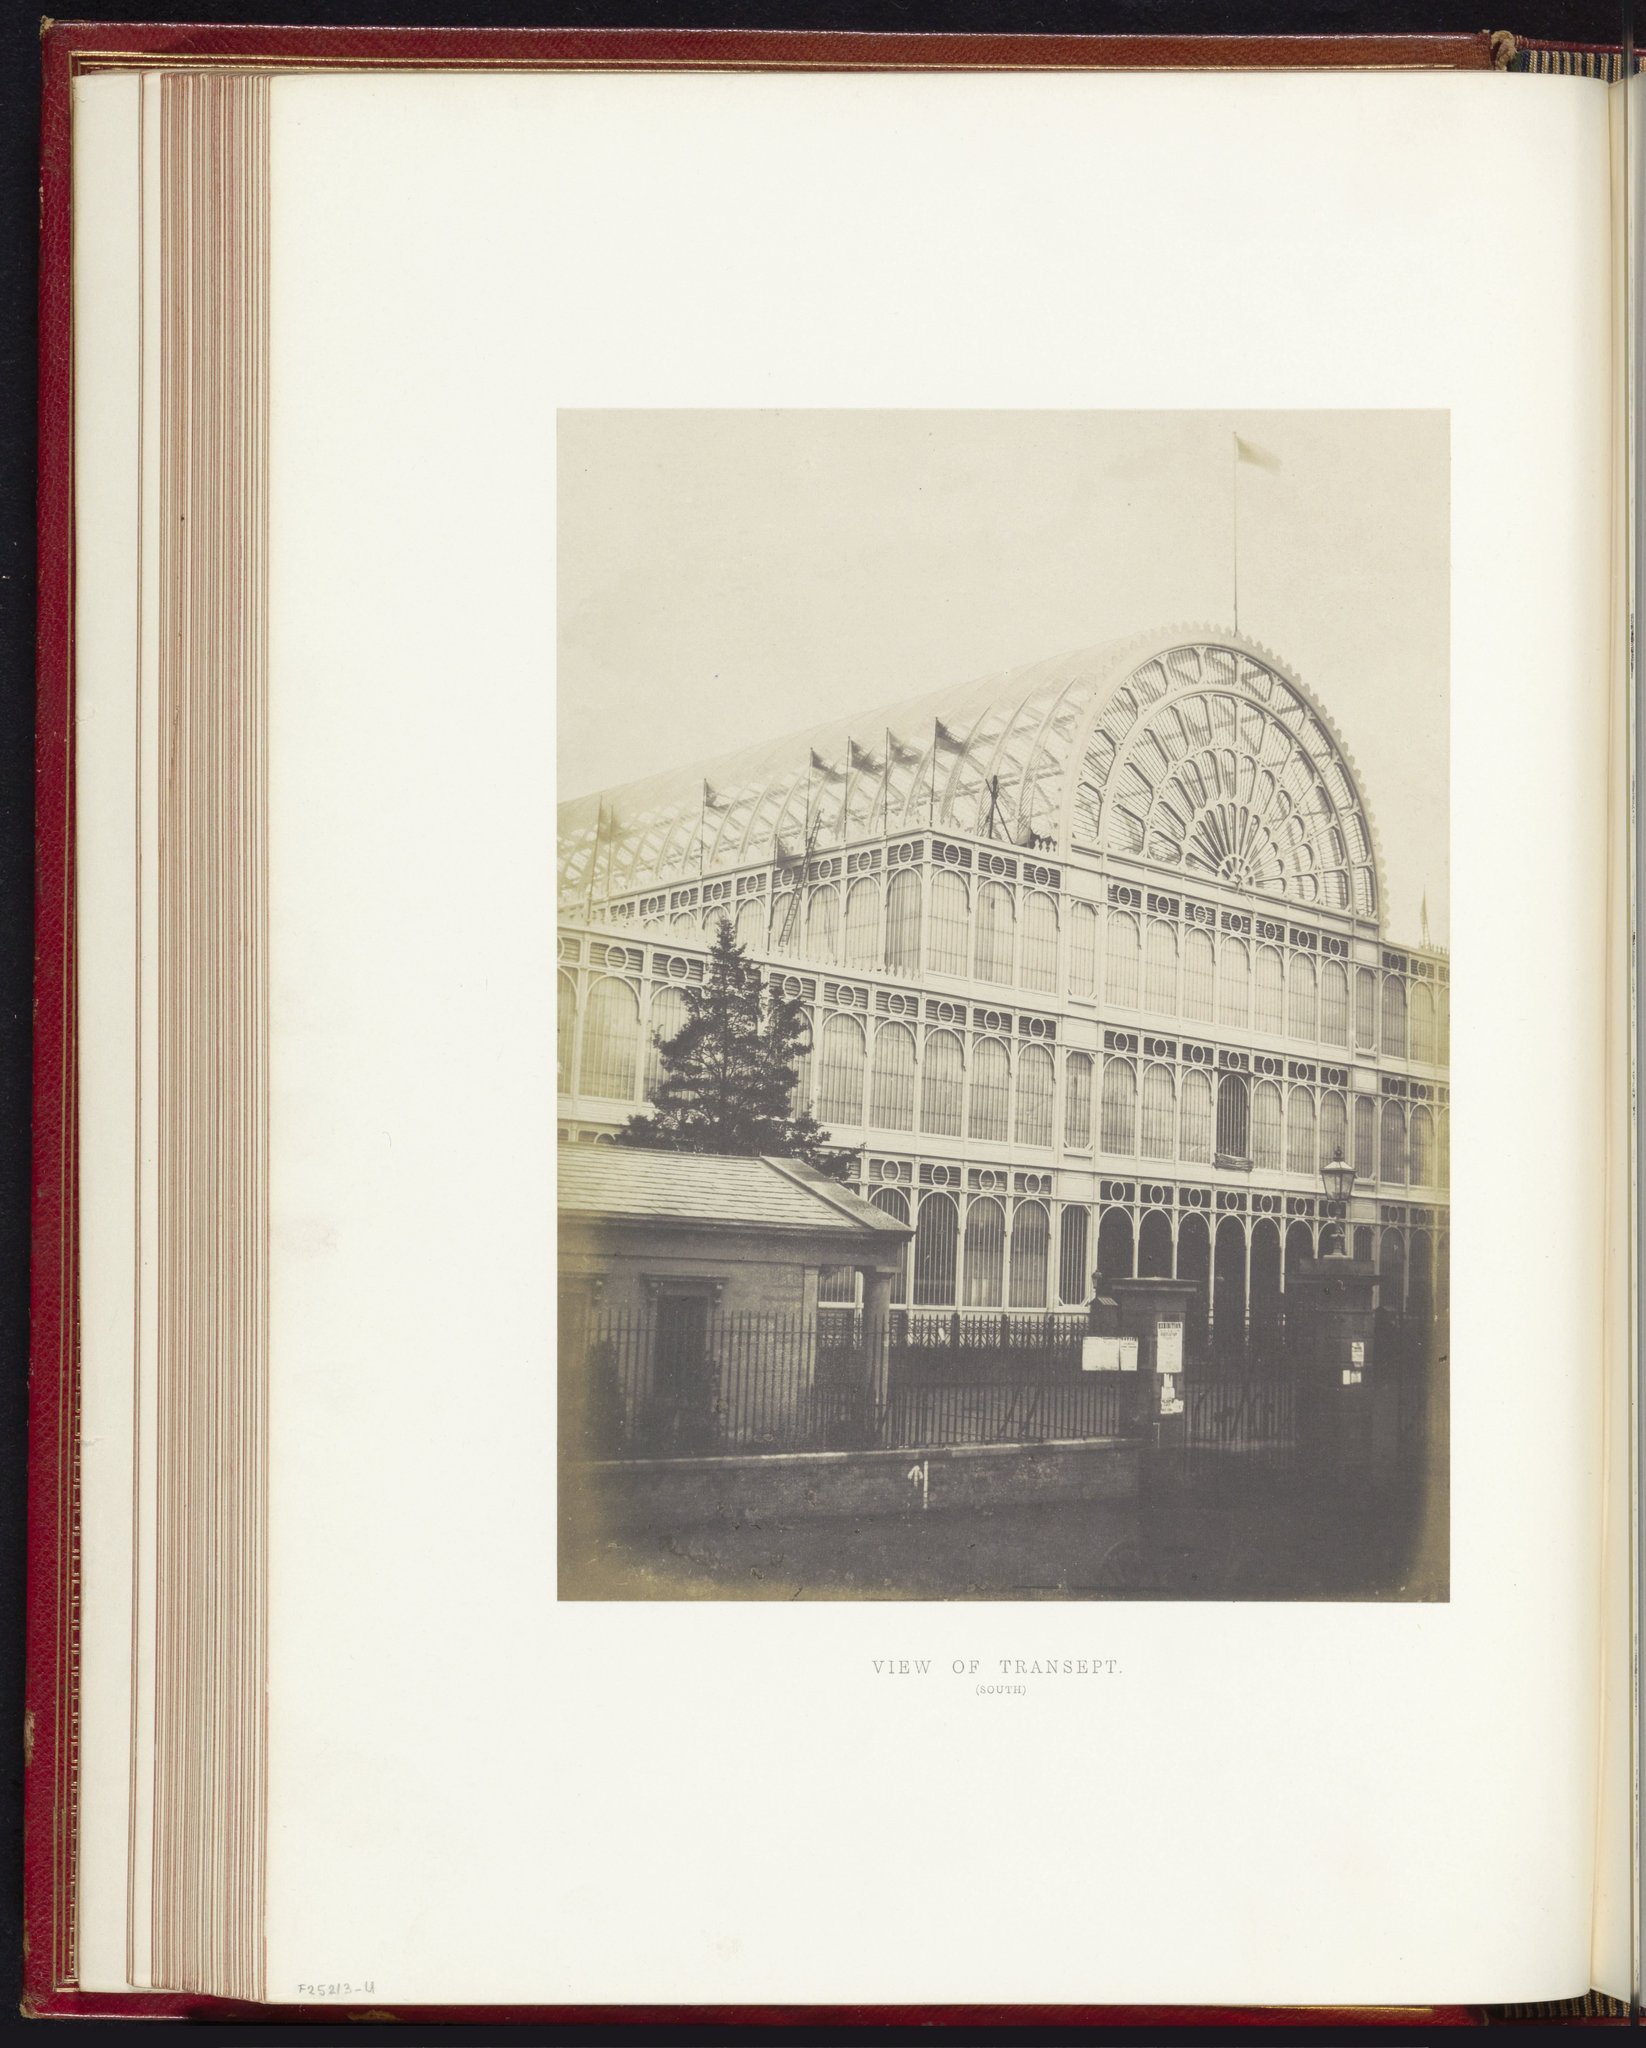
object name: page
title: Gezicht op het Crystal Palace in Londen tijdens de Great Exhibition of the Works of Industry of All Nations in 1851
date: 1851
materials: photographic support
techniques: salted paper print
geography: london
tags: world fair, world exhibition